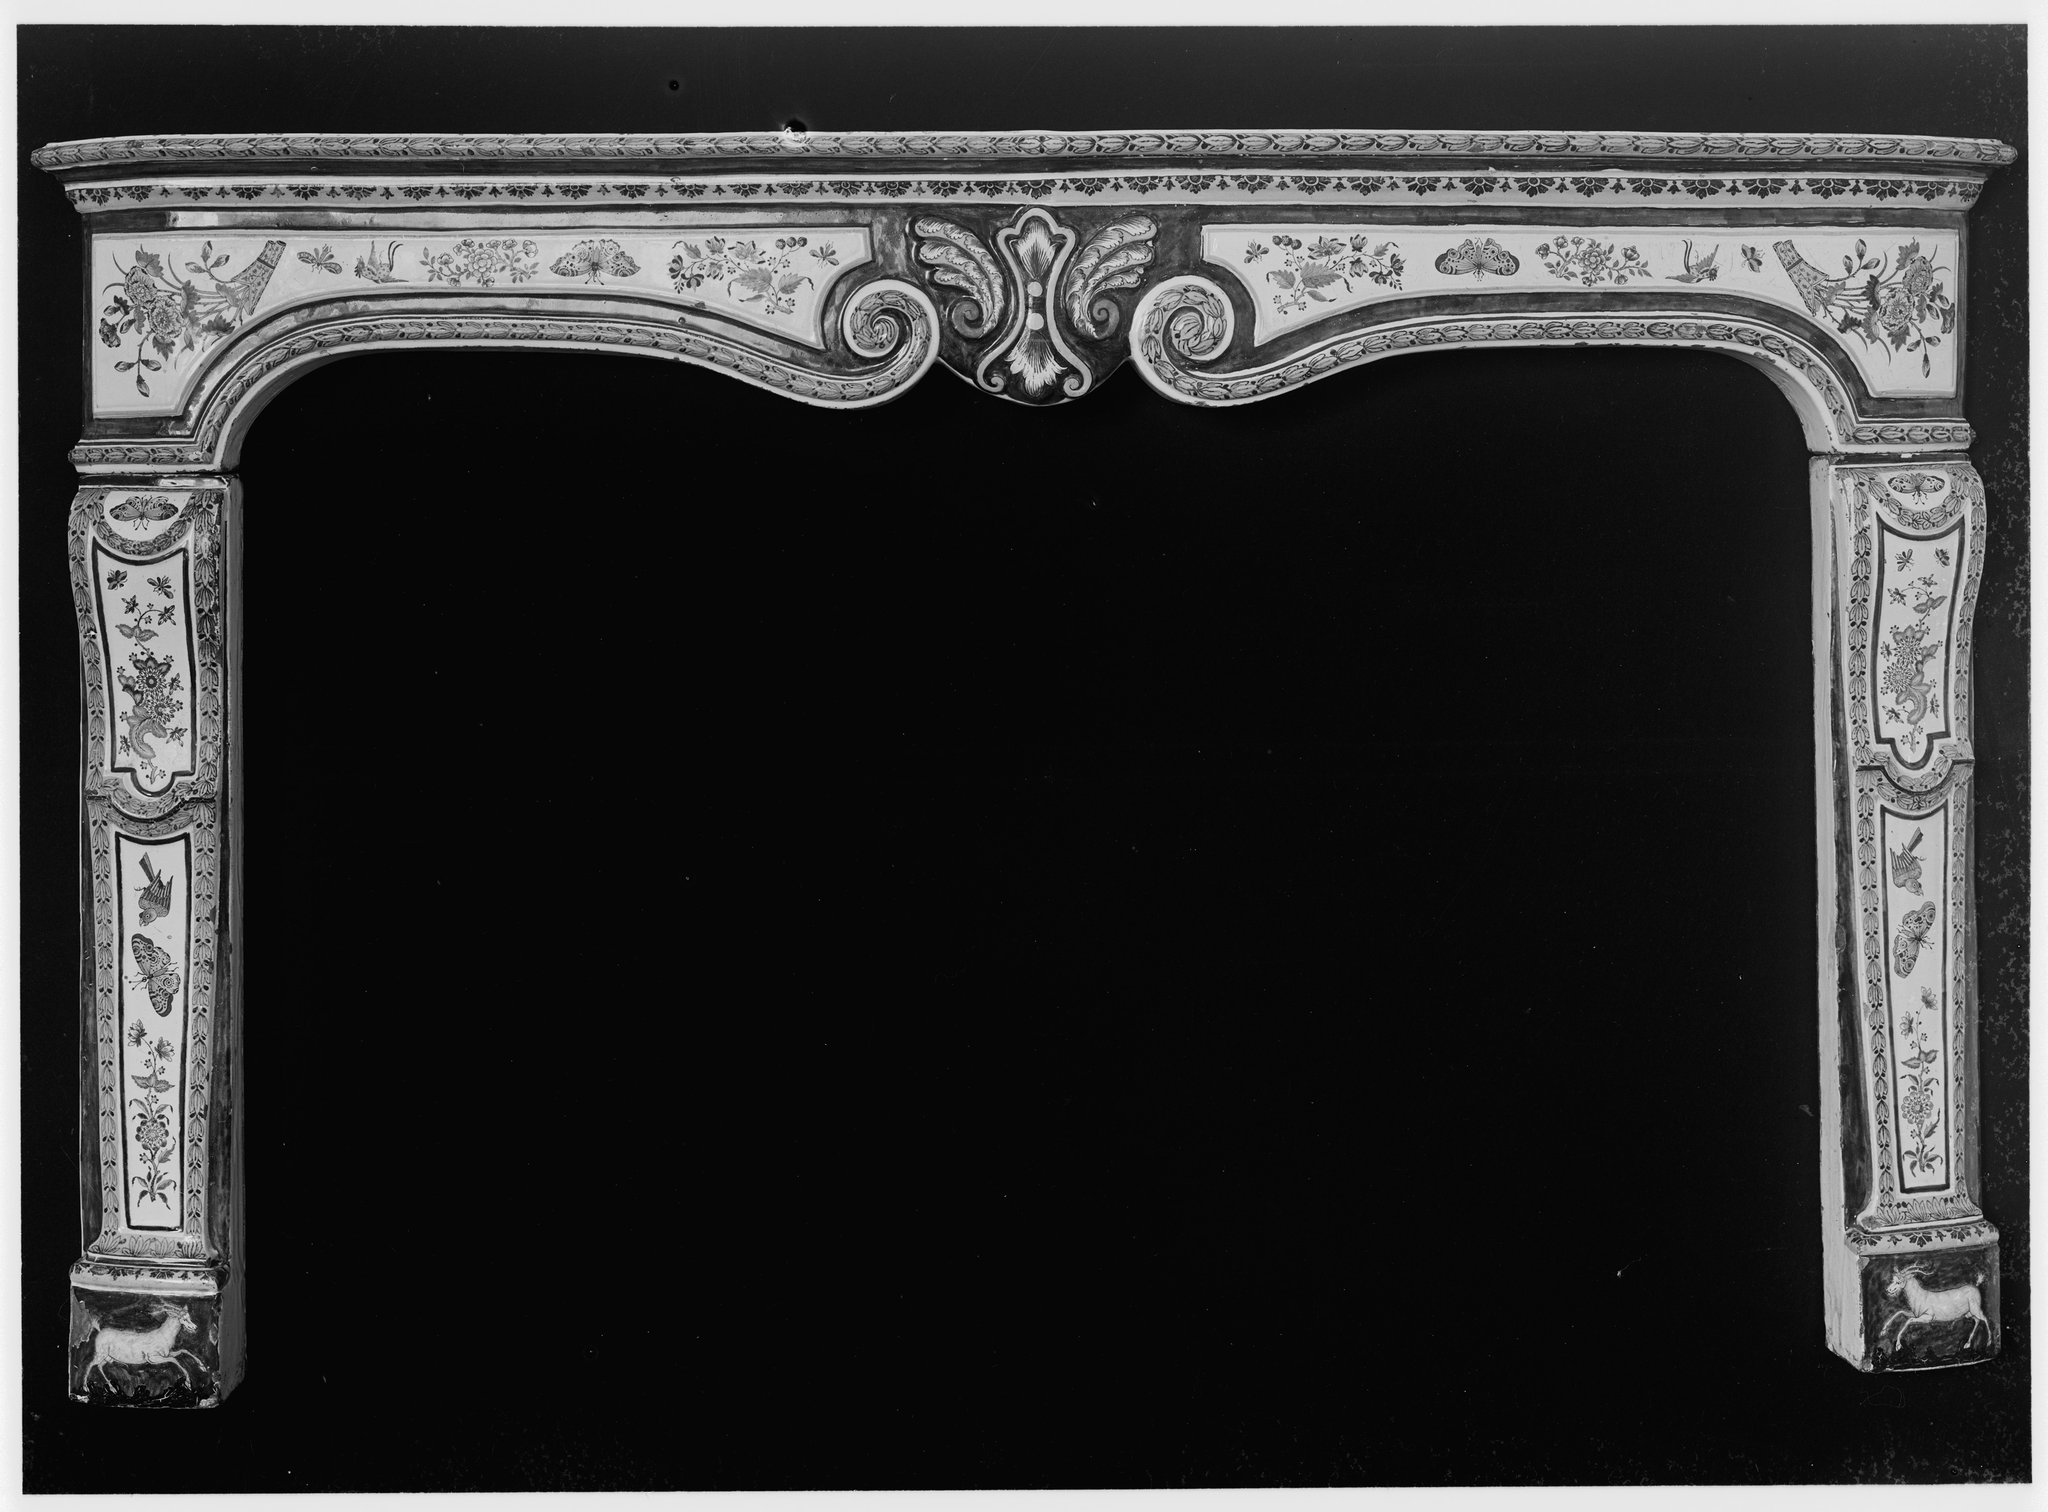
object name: chimneypiece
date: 1750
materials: pottery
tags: animals,birds,butterflies,flowers